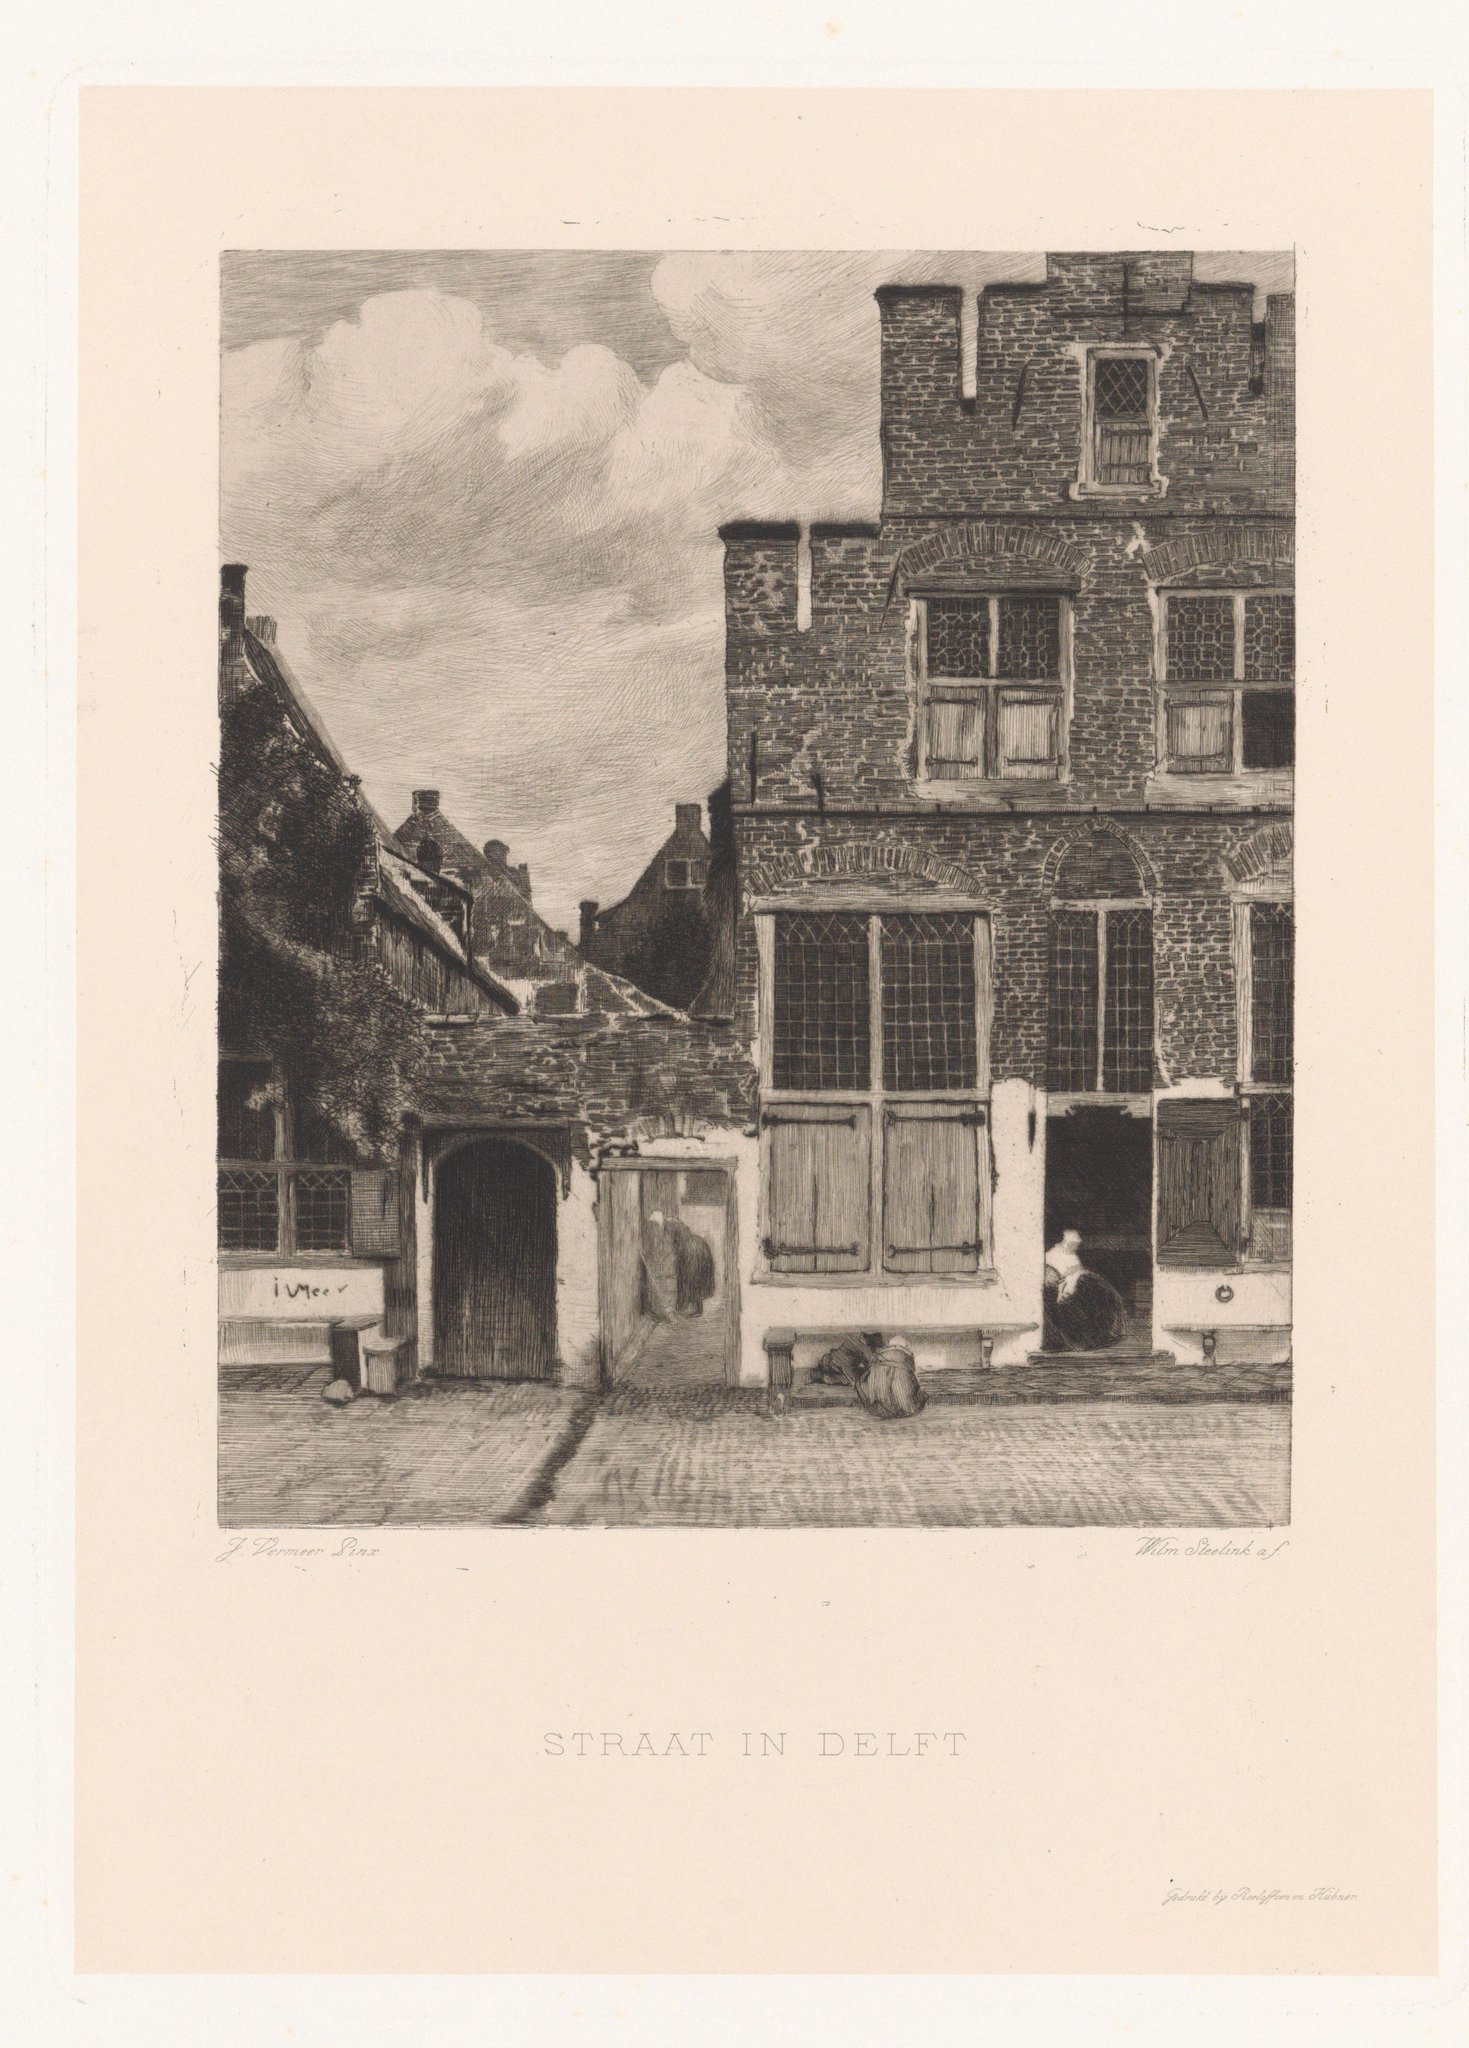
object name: print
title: Gezicht op huizen in Delft, bekend als 'Het straatje'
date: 1888-1891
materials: paper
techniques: drypoint, etching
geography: amsterdam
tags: children's games and plays (+ out of doors (sports, games, etc.)), civic architecture; edifices; dwellings, street, delft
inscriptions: collector's mark: Lugt 2228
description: Gezicht op huizen in Delft, bekend als 'Het straatje'. De gevels van enkele huizen aan een straat in Delft. Tussen de huizen een steegje waar een vrouw over een wastobbe gebogen staat. In de openstaande deur van het huis rechts zit een vrouw te handwerken, links voor het huis op de stoep twee spelende kinderen.